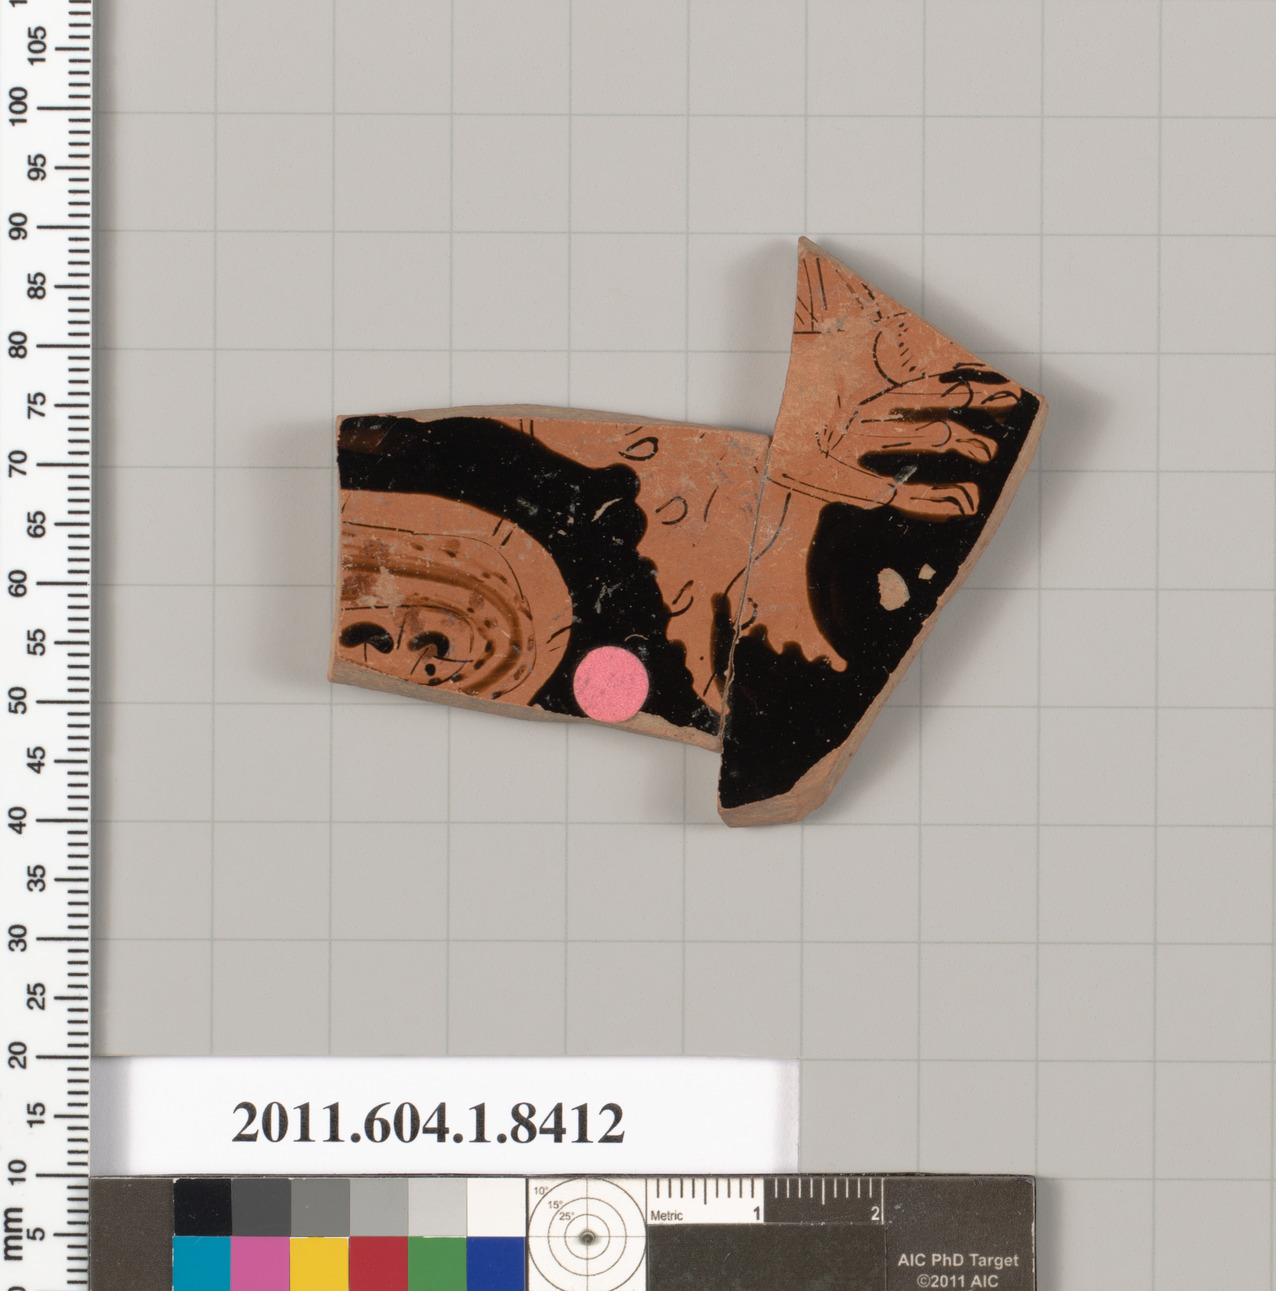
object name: kylix fragment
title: Terracotta fragment of a kylix (drinking cup)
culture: greek, attic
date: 434-368 BCE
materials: terracotta